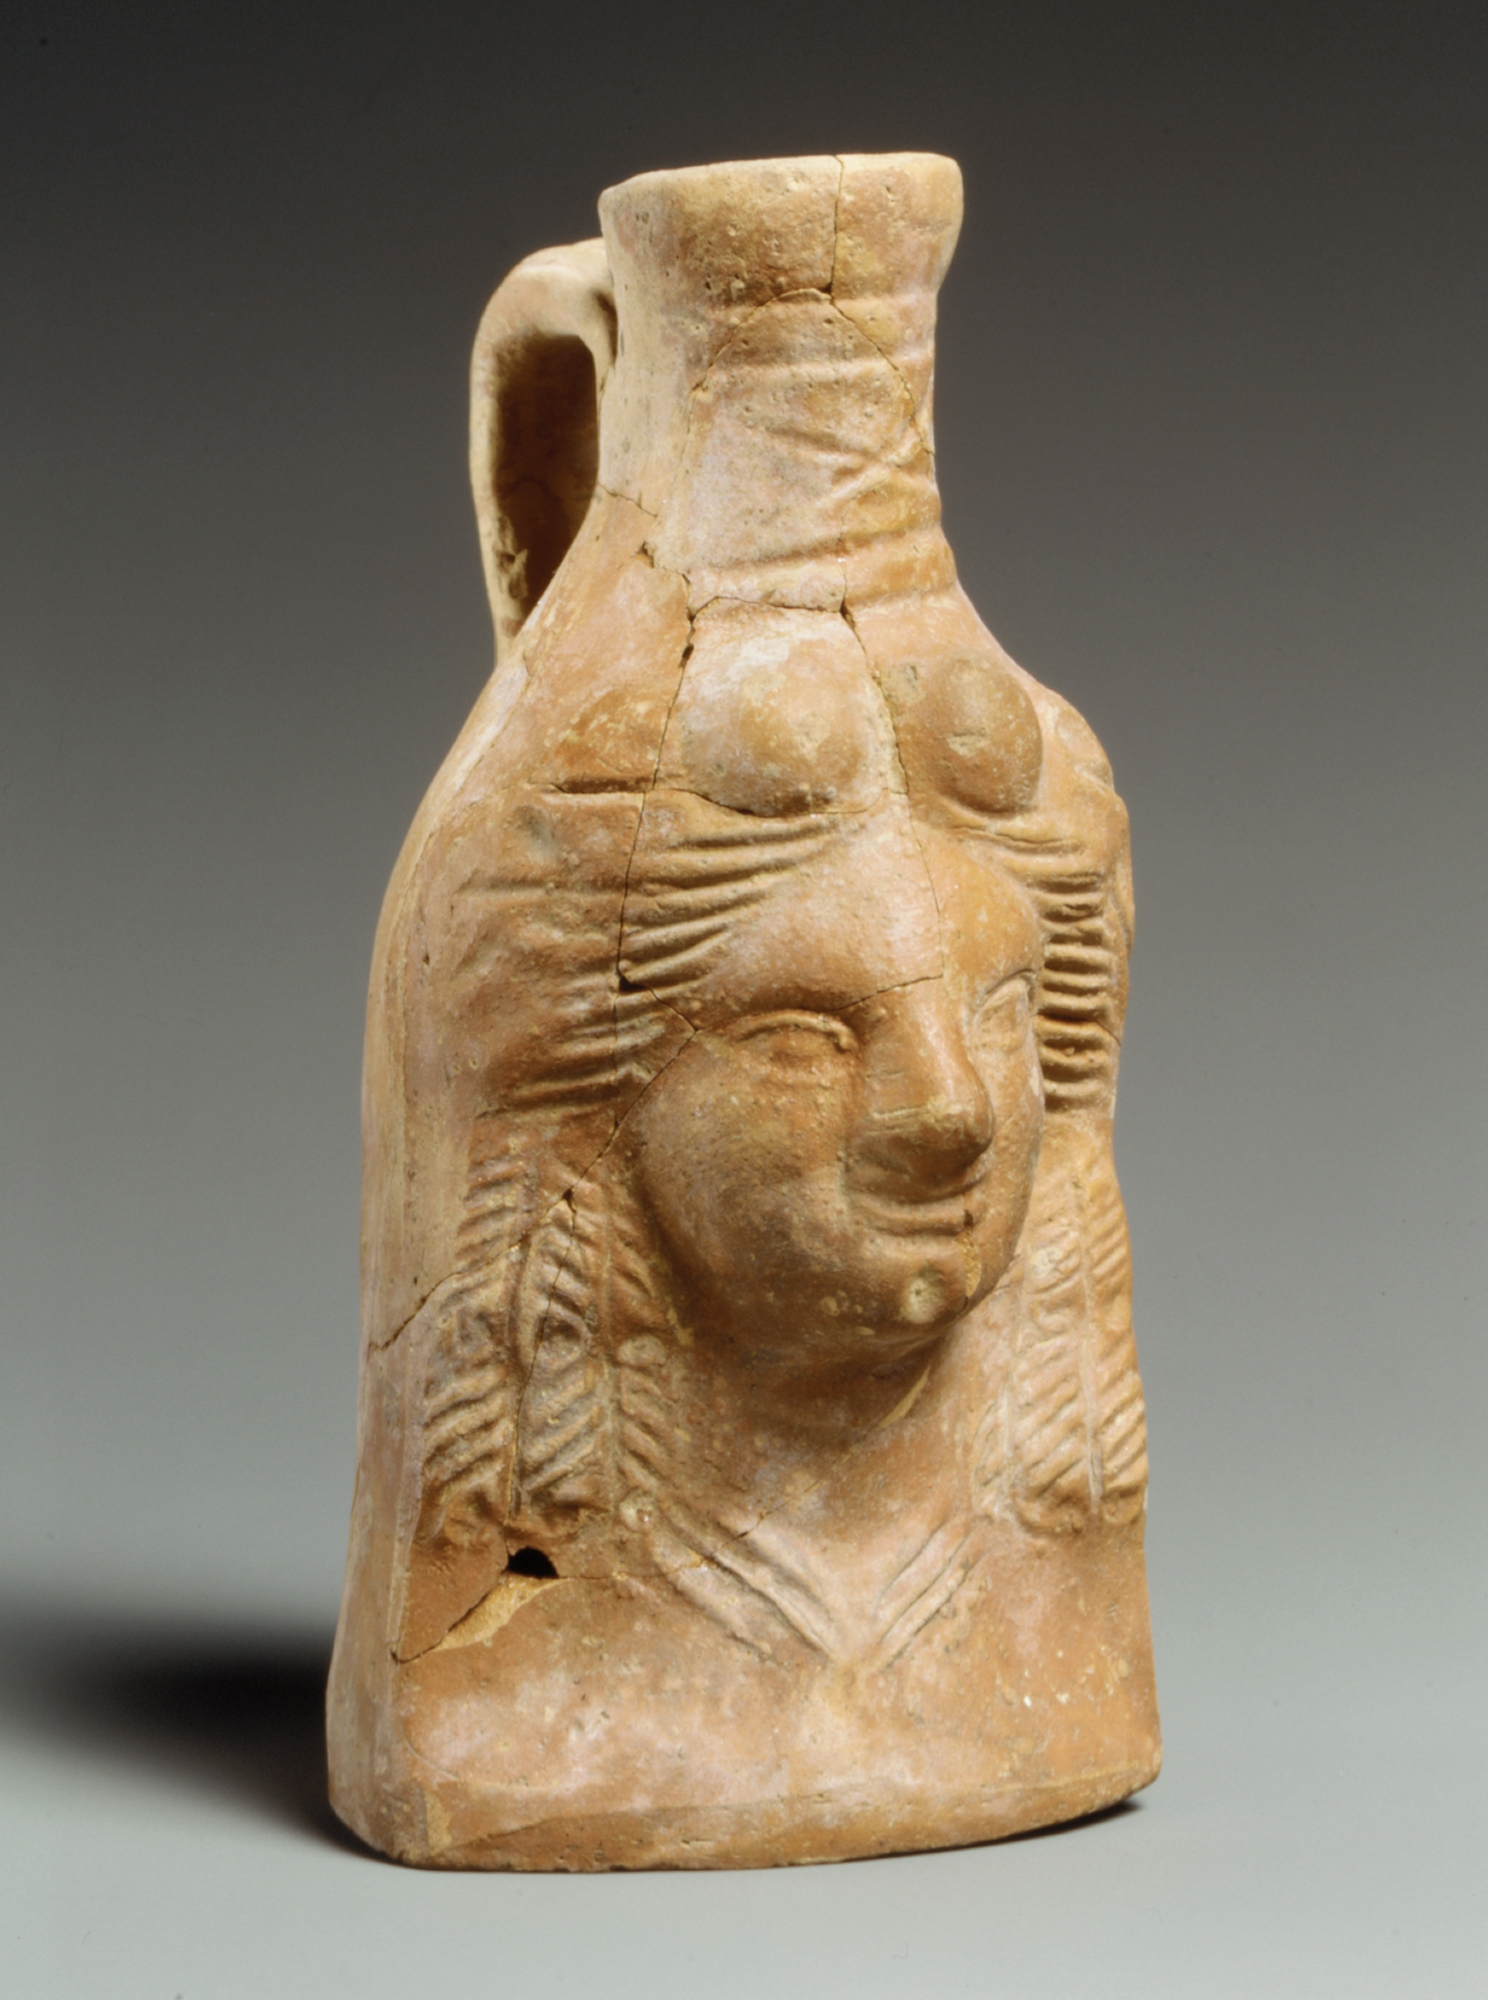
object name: flask, double head shaped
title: Terracotta head-shaped flask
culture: greek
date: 80-1 BCE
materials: terracotta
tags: heads